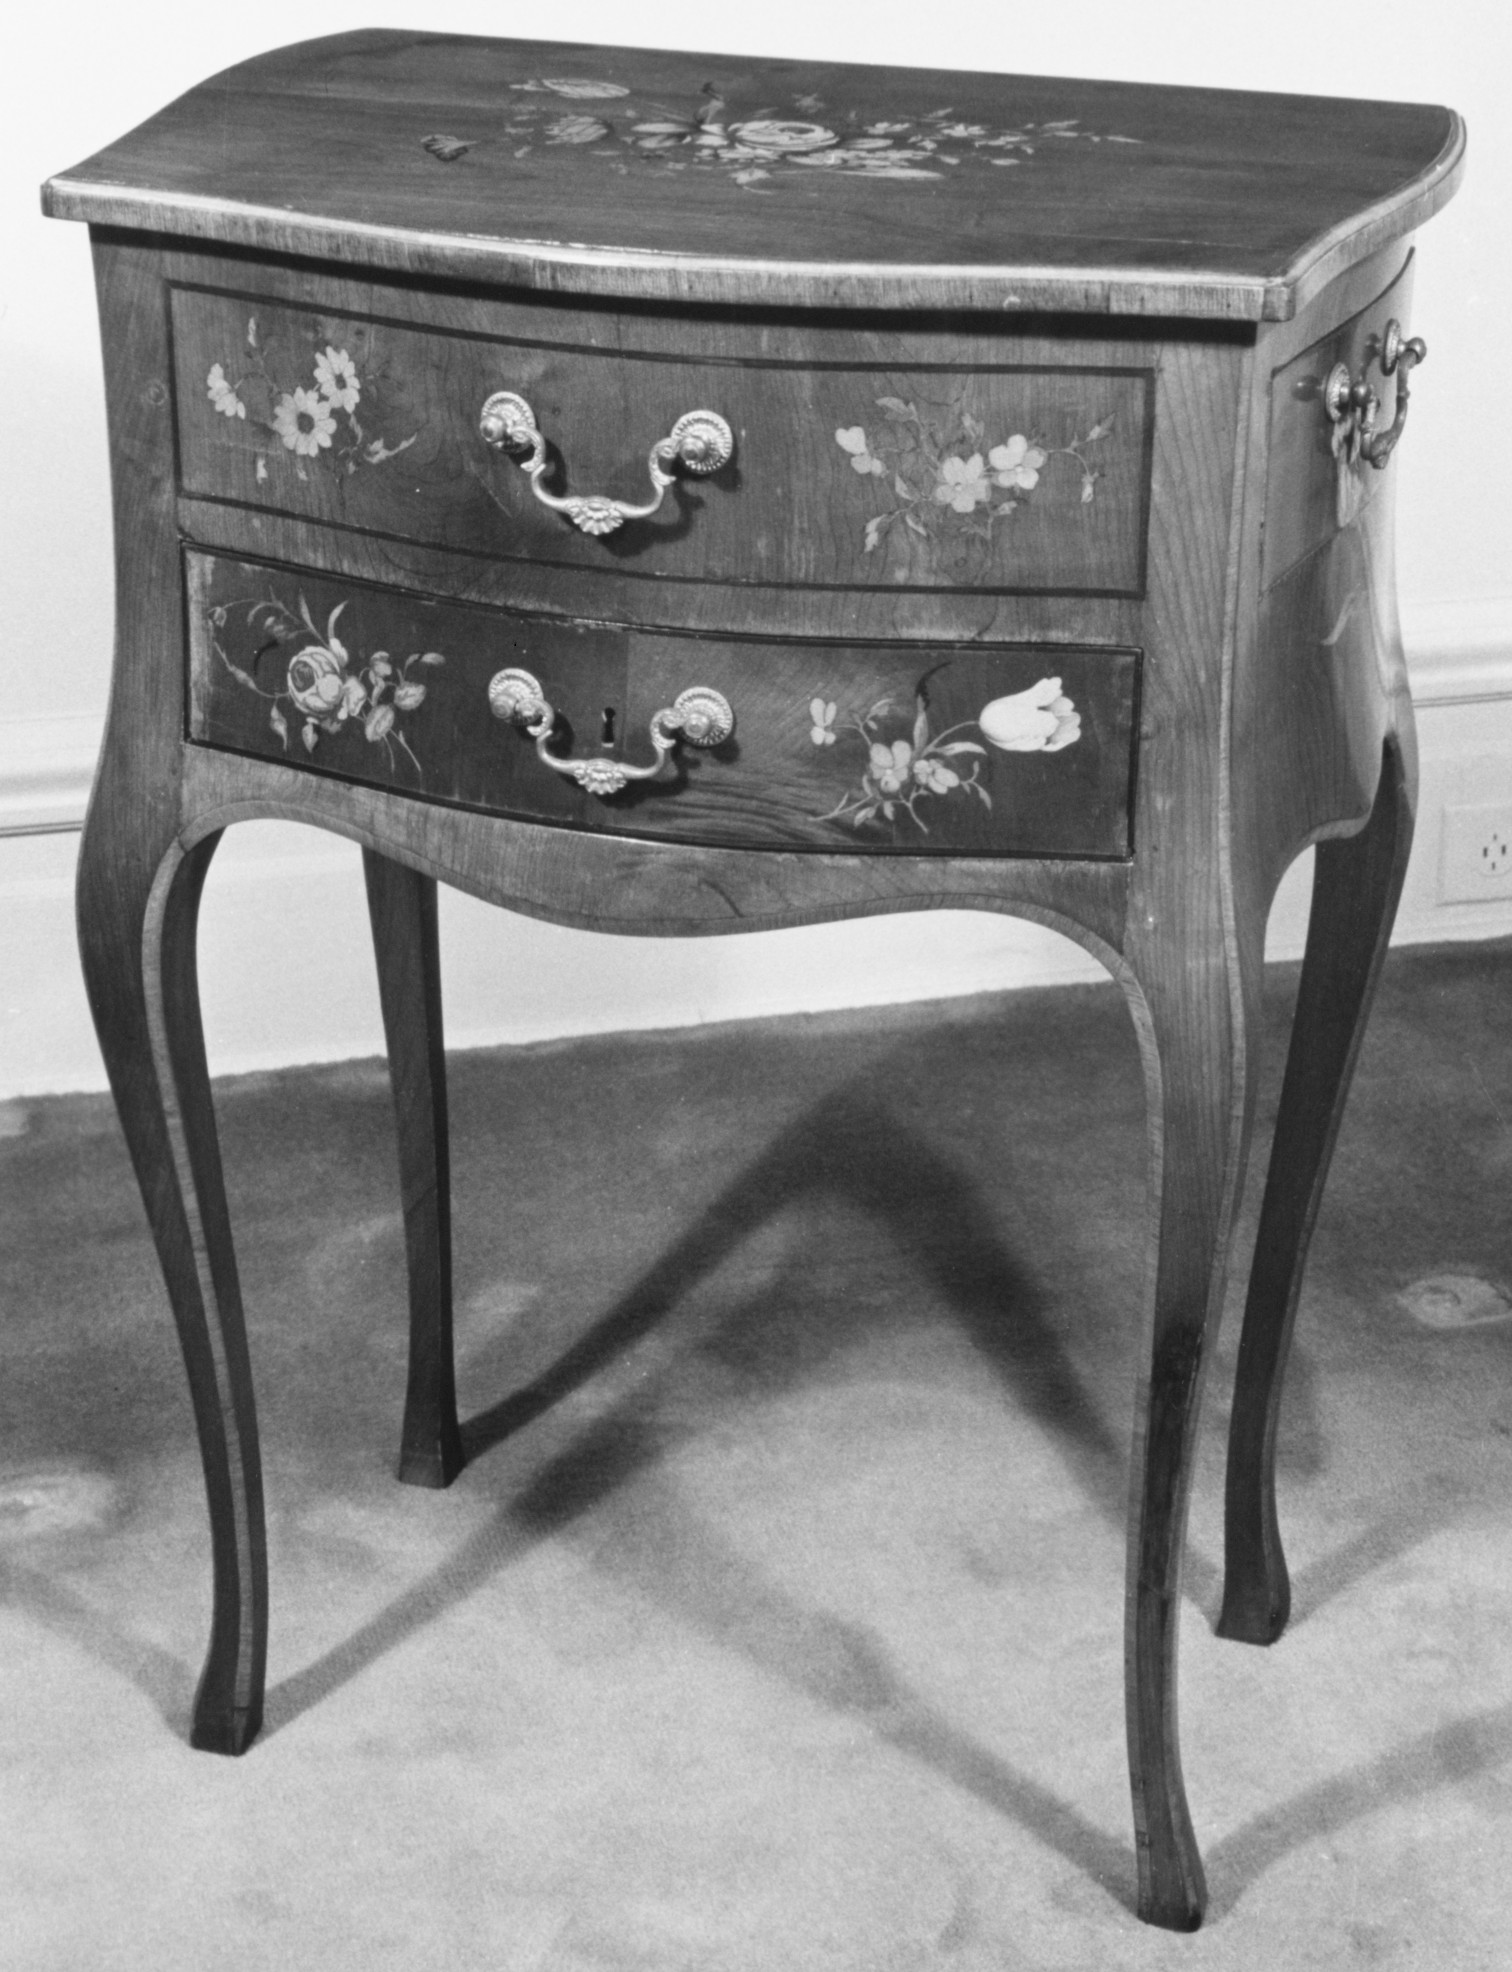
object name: dressing table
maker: david roentgen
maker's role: maker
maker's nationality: german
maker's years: 1743-1807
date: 1775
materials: wood